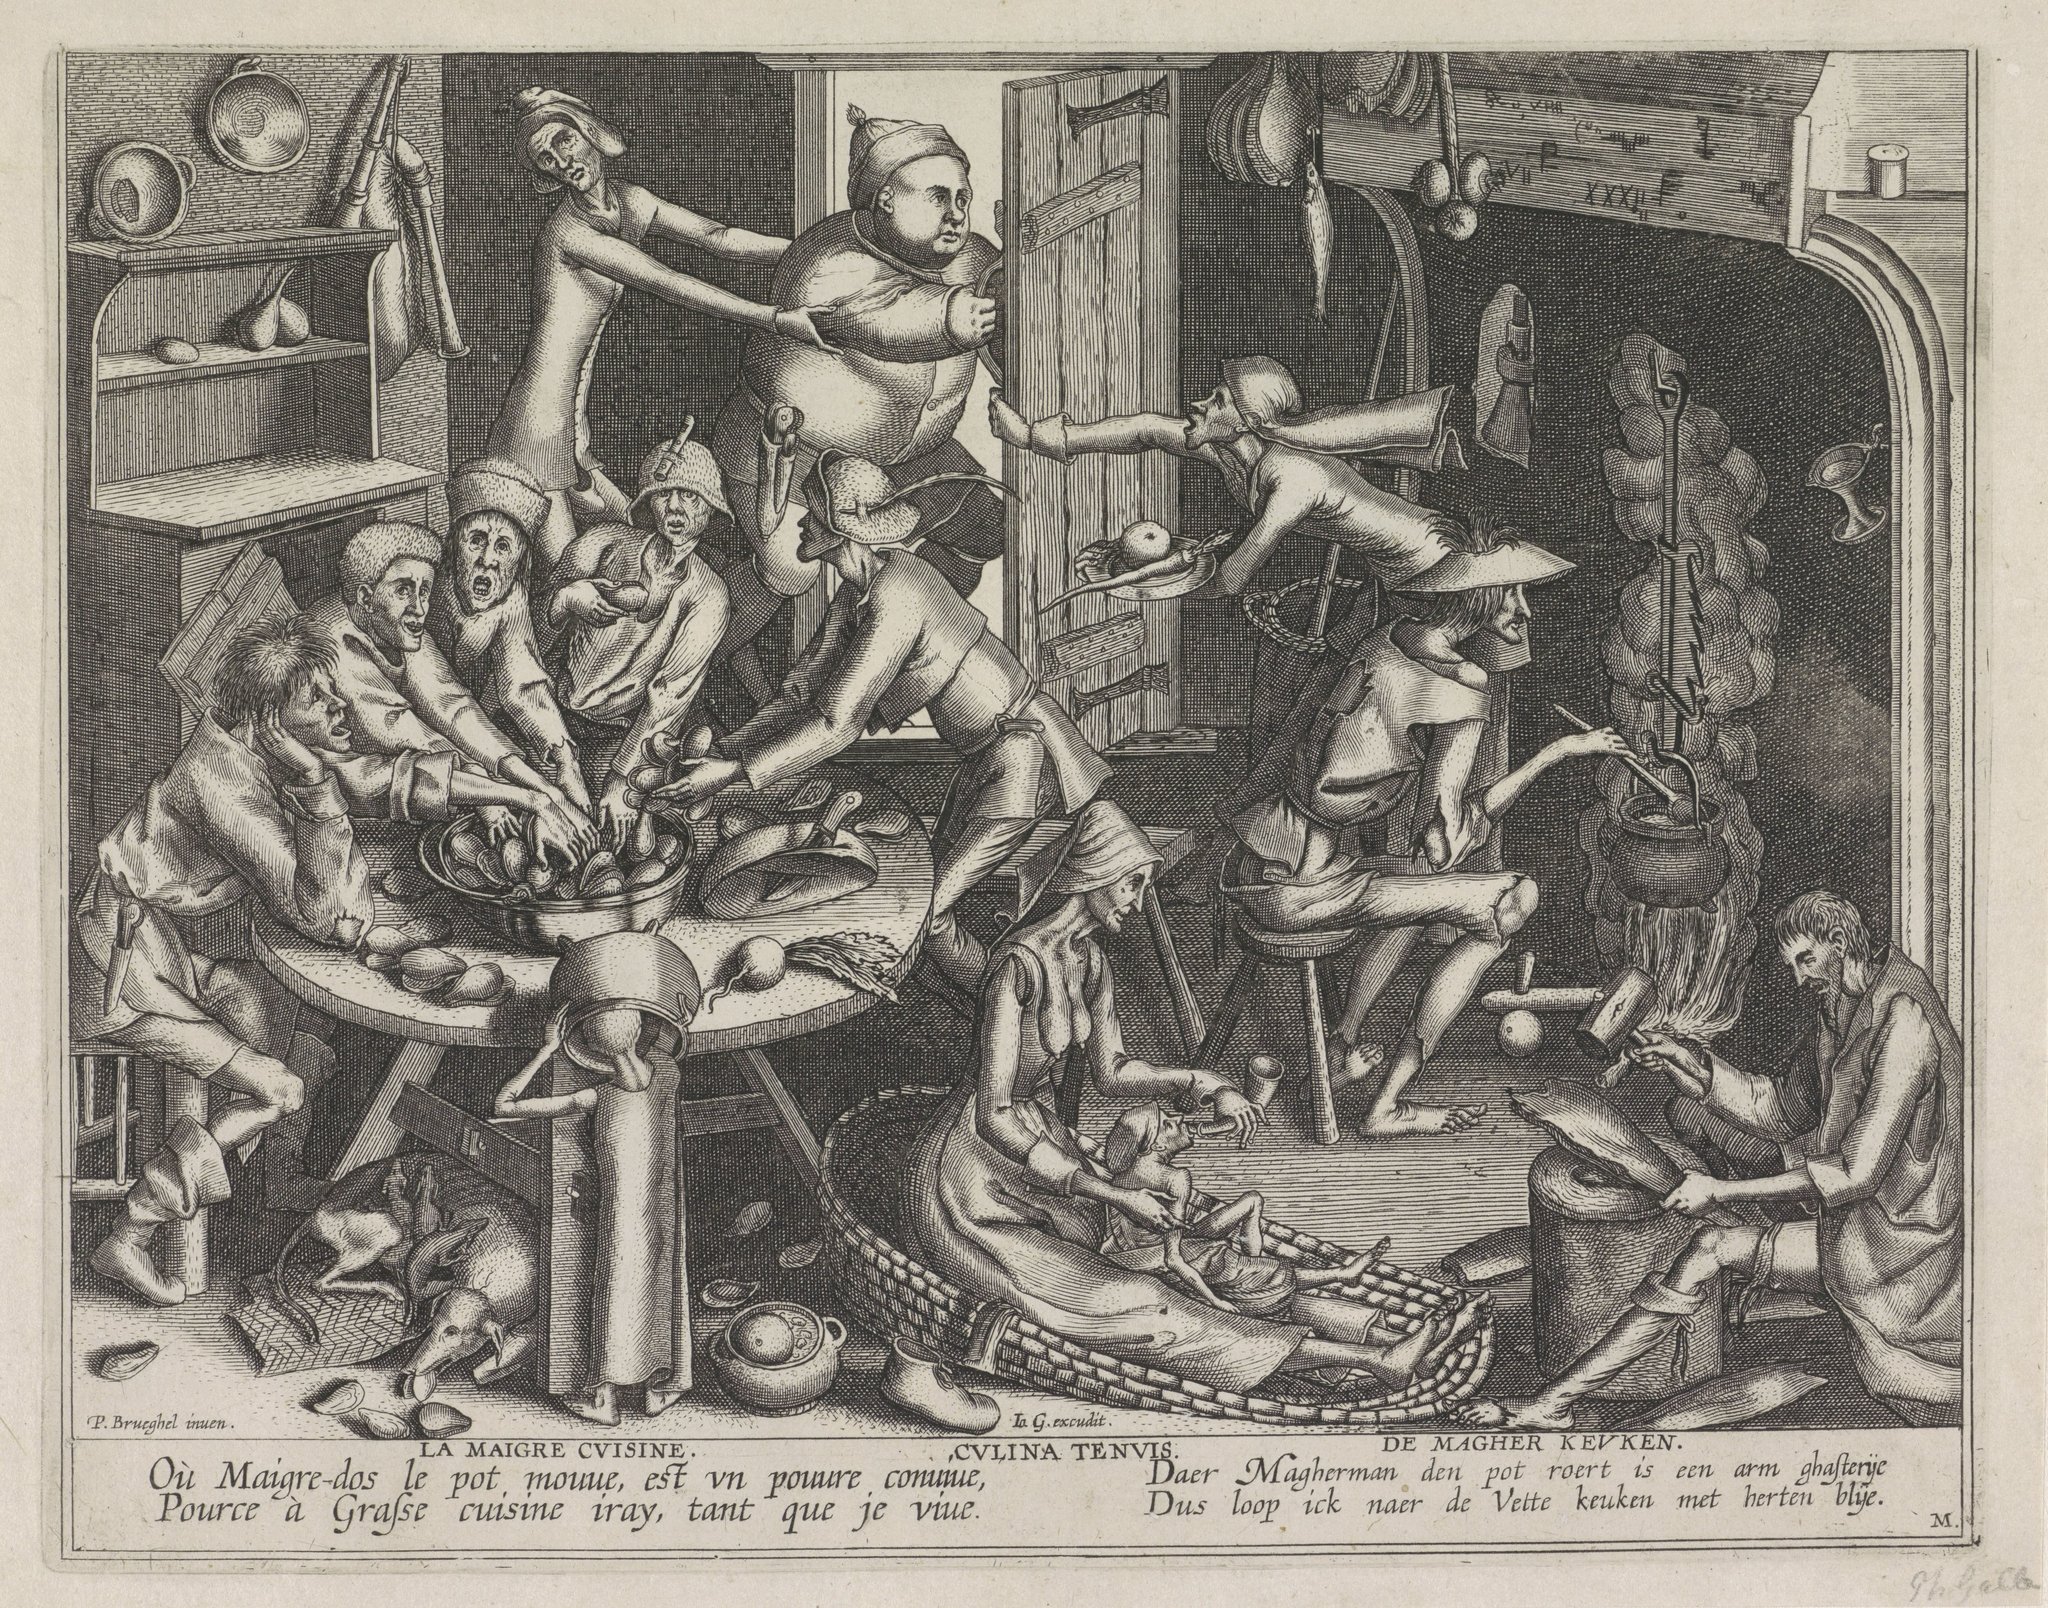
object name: print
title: Magere keuken en de vette keuken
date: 1615-1676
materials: paper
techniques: engraving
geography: antwerp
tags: nursing-chair (dutch: 'bakermat'), thin (human type), kitchen-interior, poor kitchen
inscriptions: collector's mark: Lugt 2228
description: Keukeninterieur met magere mensen die aan een tafel mosselen eten. Een man roert in een ketel op het vuur en vooraan geeft een vrouw een kind uit een drinkhoorn te drinken. Boven probeert een dikke man de magere keuken te ontvluchten, terwijl twee magere mensen hem proberen binnen te halen. Onder de voorstelling een tweereglig vers in het Frans en in het Nederlands.